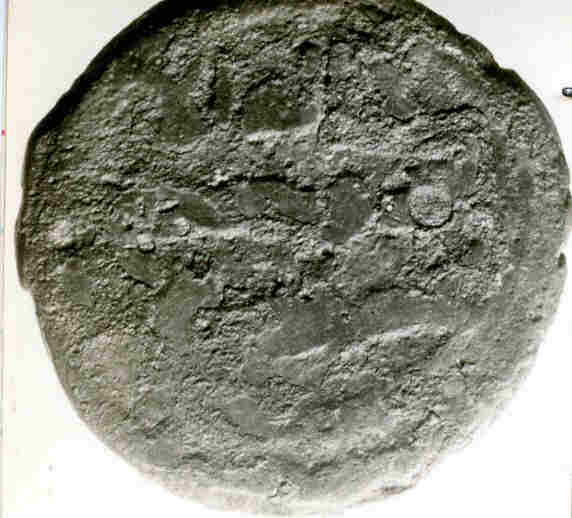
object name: coin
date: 701-1300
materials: copper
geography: iran